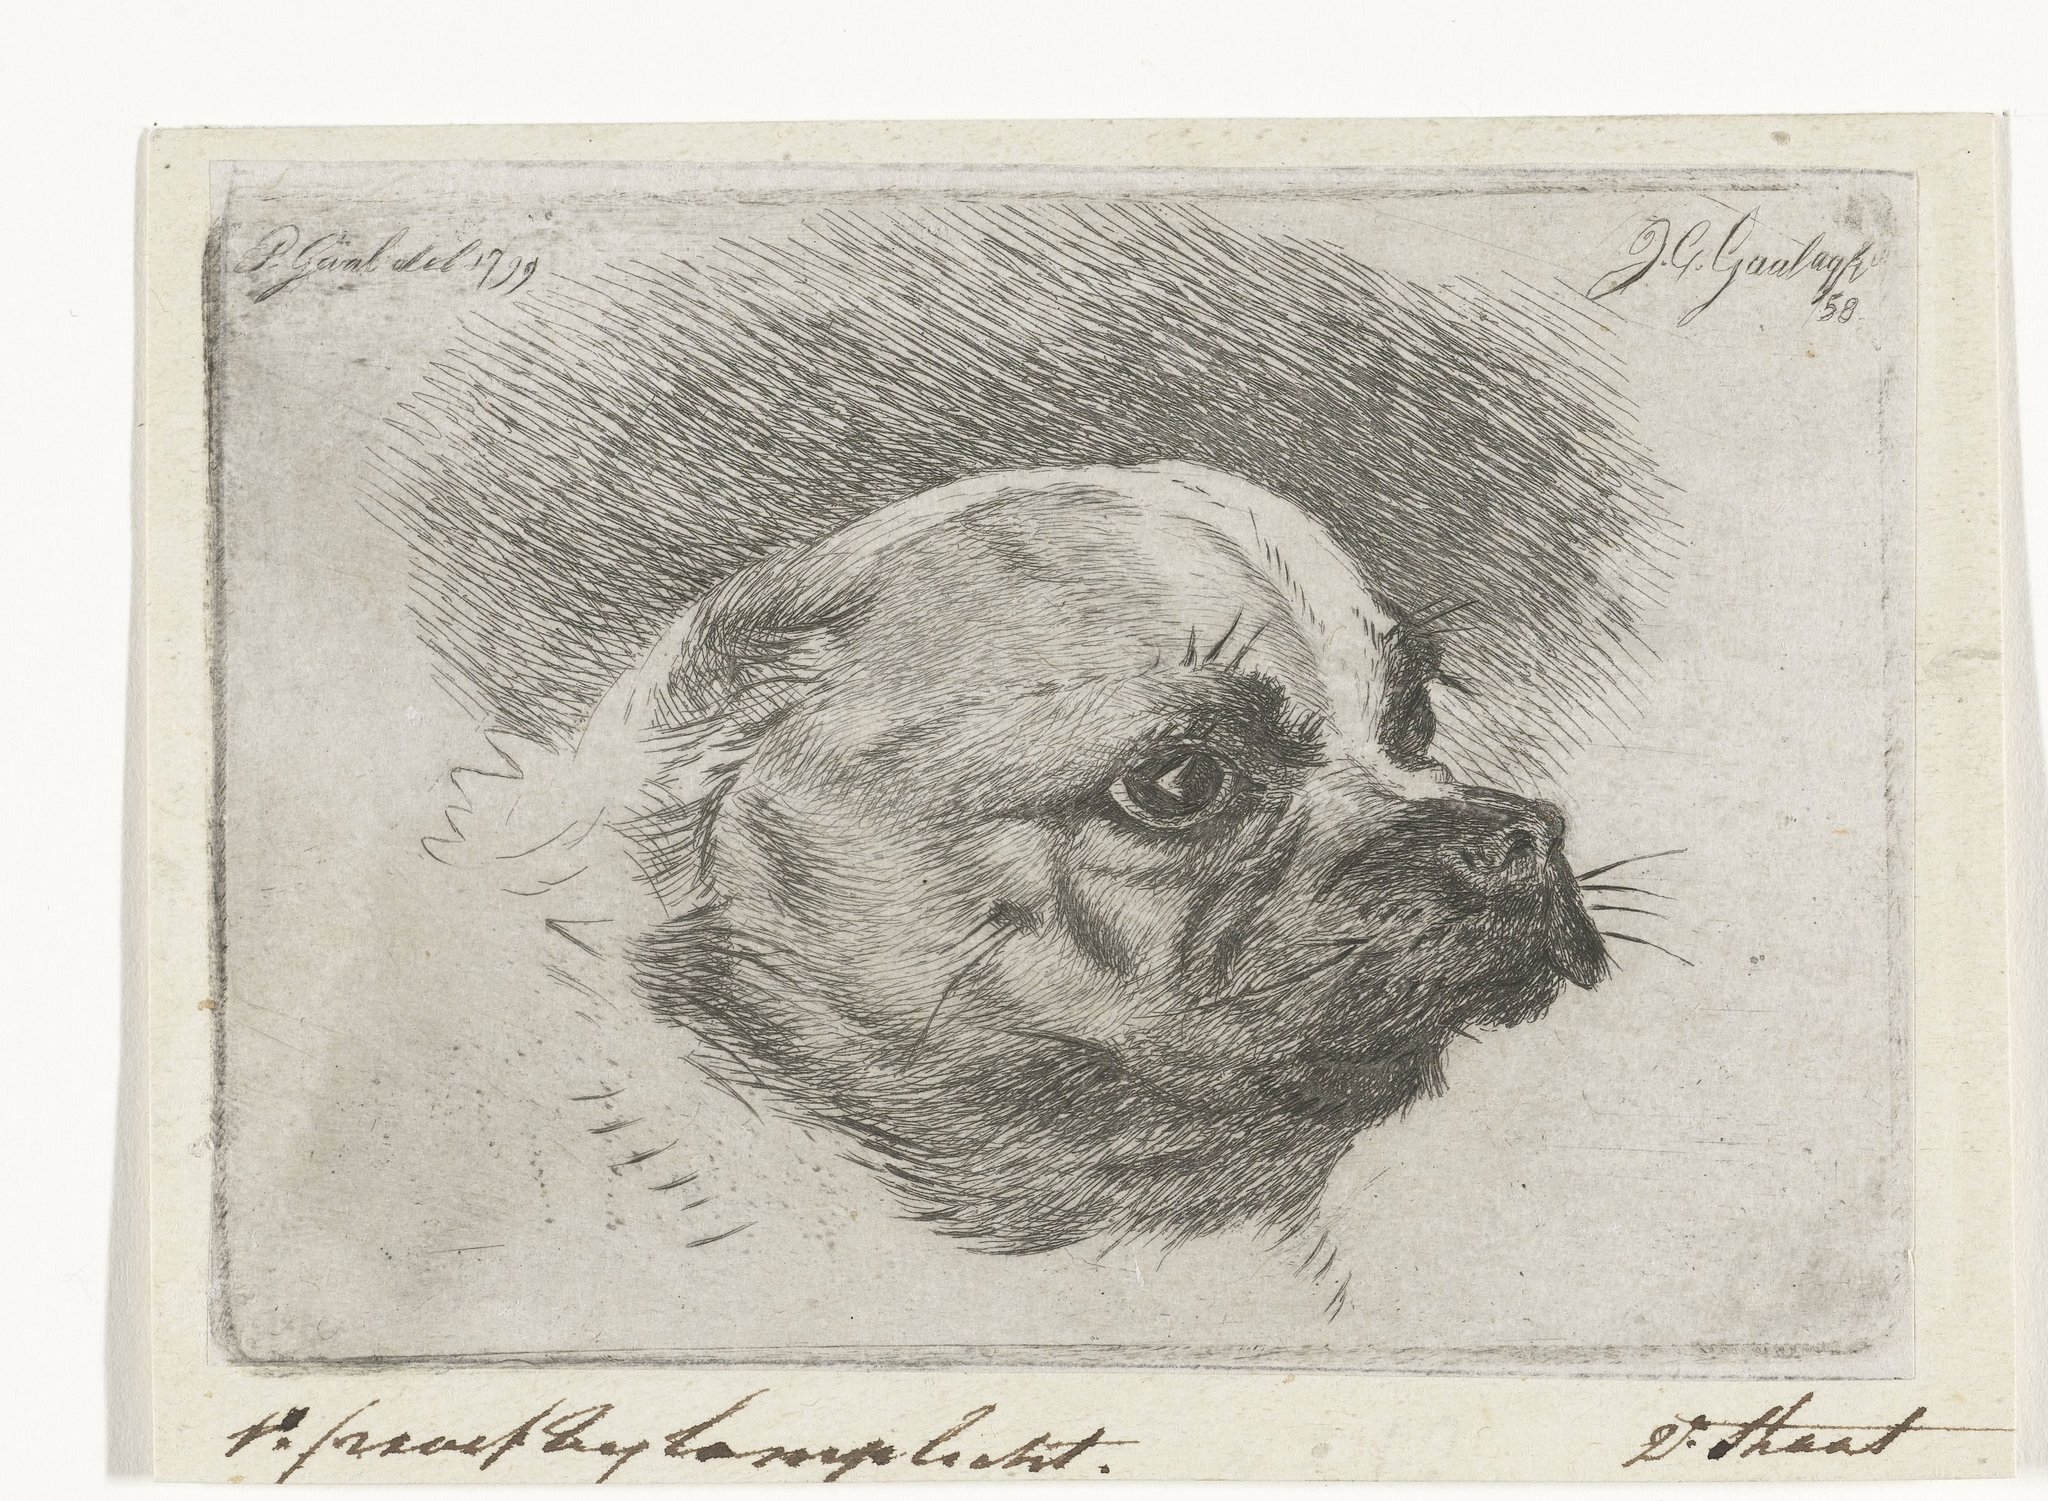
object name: print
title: Kop van een mopshond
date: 1858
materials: paper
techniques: etching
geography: netherlands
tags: dog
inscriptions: collector's mark: Lugt 2228